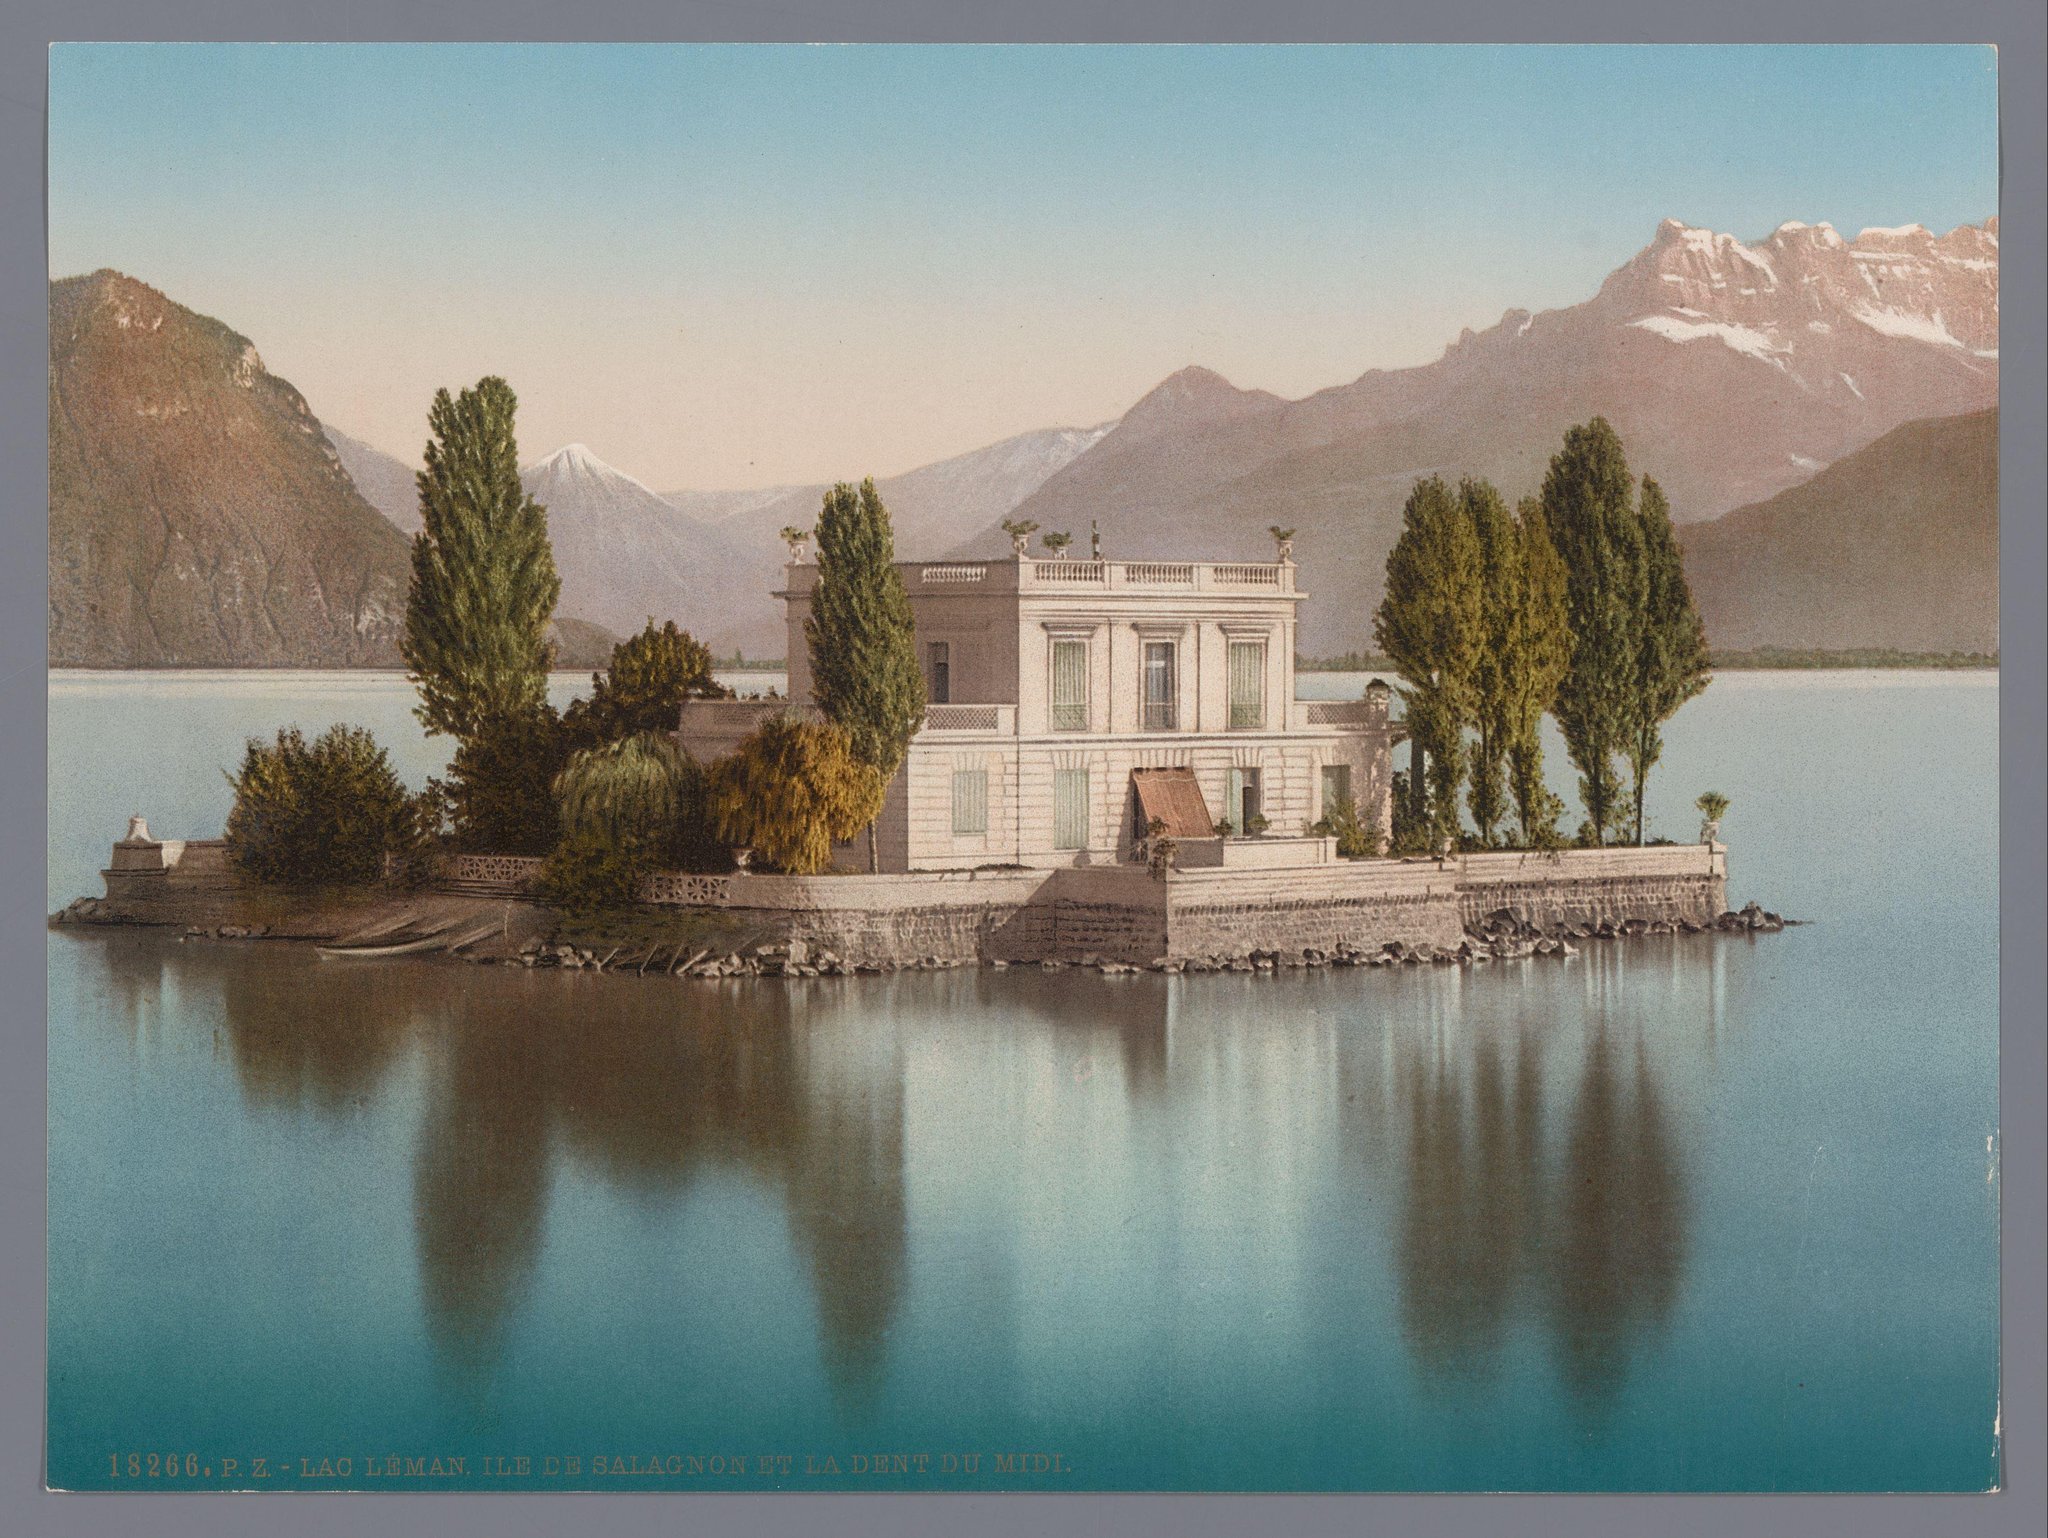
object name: photomechanical print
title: lac Léman, Ile de Salagnon et la Dent du Midi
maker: Anonymous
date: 1889-1920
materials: paper, photographic process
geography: lake geneva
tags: island, lake, villa, mountains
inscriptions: number: ‘18266.’